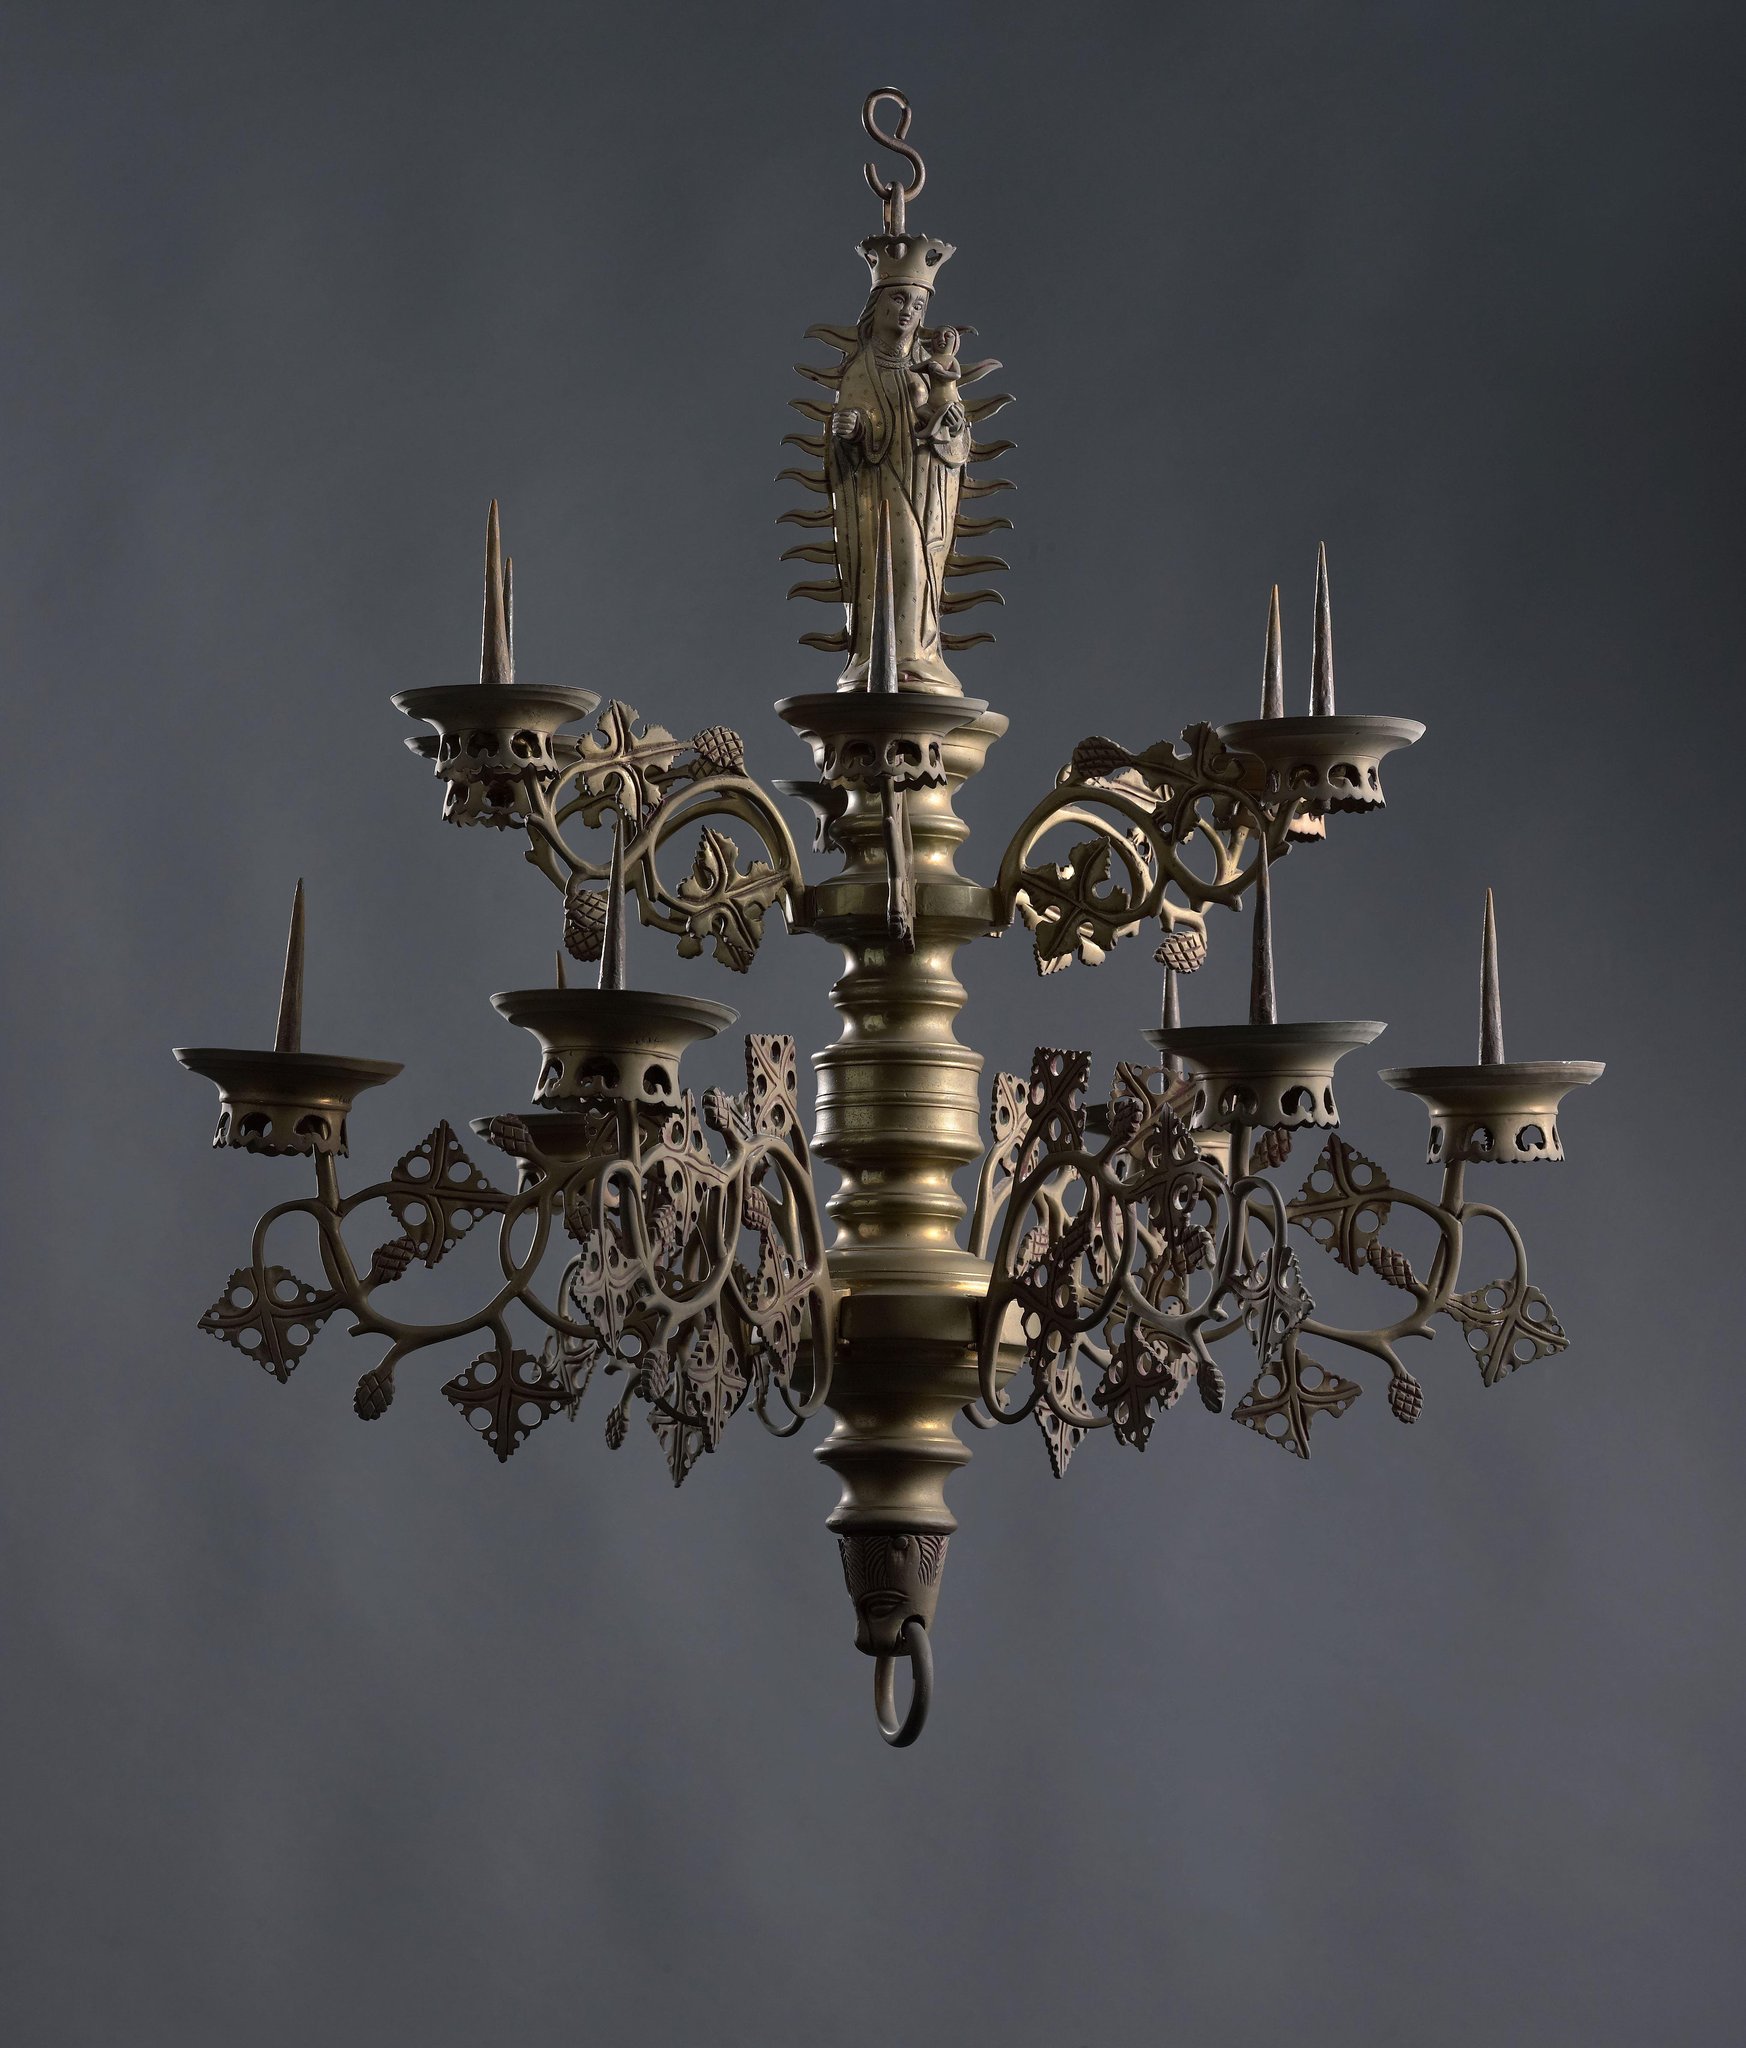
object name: chandelier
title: Arm met kaarsenhouder van kaarsenkroon van twee hoogten met ieder zes armen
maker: Anonymous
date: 1475-1500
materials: brass, iron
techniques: casting, metalworking, forging, screwed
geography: southern netherlands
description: Kaarsenarm behorende bij een kaarsenkroon van twee hoogten met Mariafiguur bovenaan. De arm is twee maal gebogen en is versierd met vier druiventrossen en vijf wingerdbladeren. De ronde vetvanger heeft aan de onderkant opengewerkte, gekartelde verticaal geplaatste randen, ter maskering van de bevestiging op de arm. Dit geschiedt door een ronde ijzeren pin, die in het einde van de arm is geschroefd. Dit is de zesde arm van de onderste ring, ongenummerd. De vetvanger is ongenummerd.